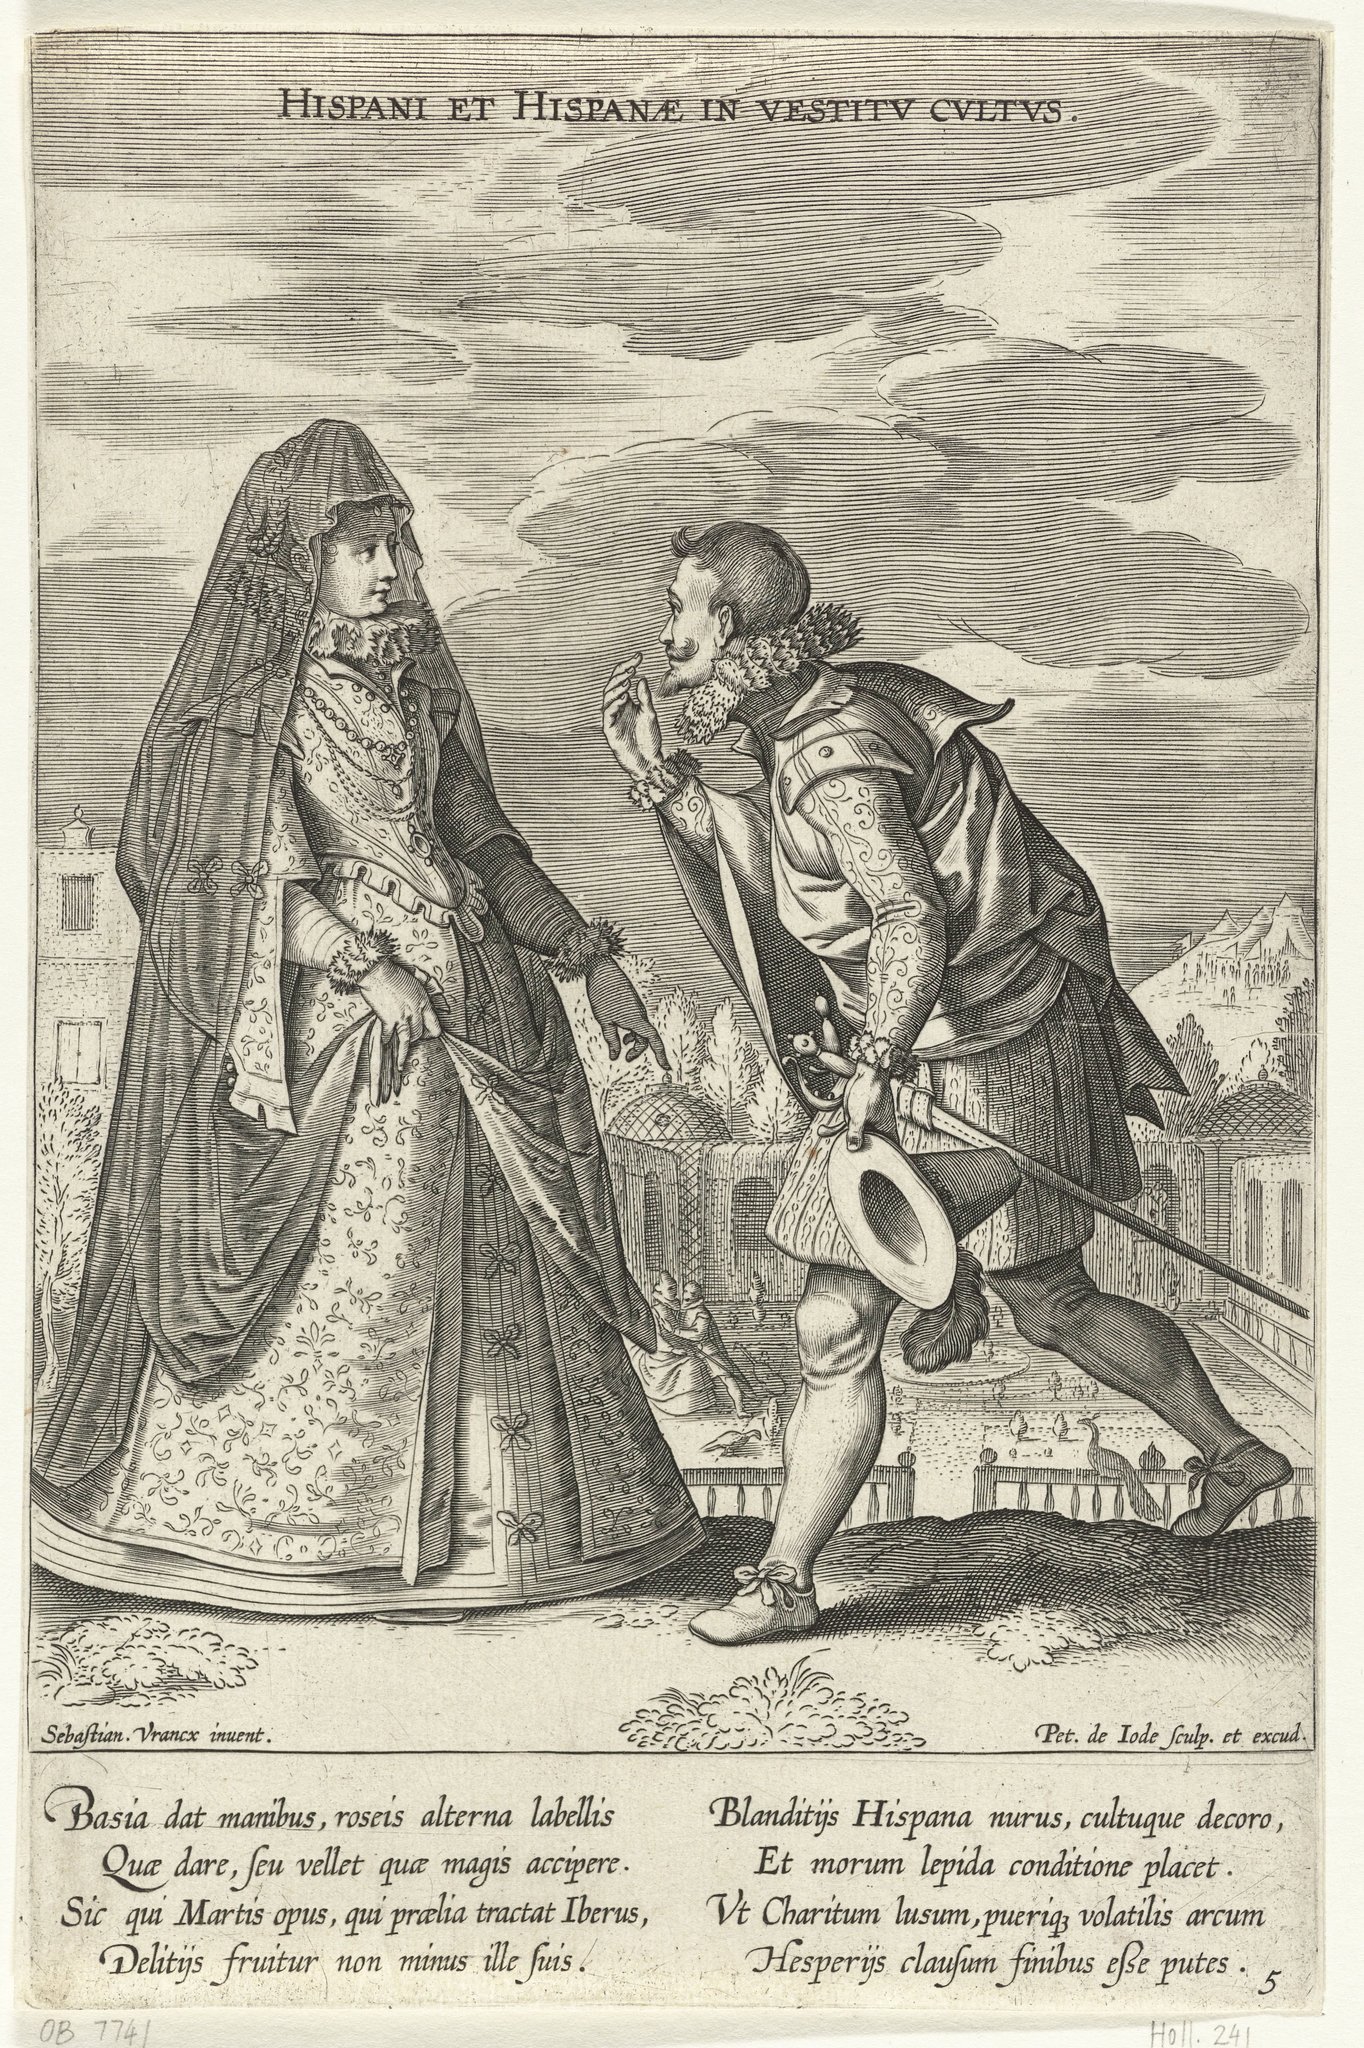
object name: costume print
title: Variarum Gentium Ornatus (Costumes of Different Nations)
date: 1605-1610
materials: paper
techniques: engraving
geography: antwerp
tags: europeans: spaniards, neck-gear ~ clothing (with name) (+ men's clothes), veil (+ women's clothes), sleeves, coat (+ men's clothes), dress, gown (vlieger) (+ women's clothes), head-gear: hat (+ men's clothes), clothes, costume (+ women's clothes), neck-gear ~ clothing (with name) (+ women's clothes), hacking and thrusting weapons: sword, shoes, sandals (+ men's clothes), clothes, costume (+ men's clothes), folk costume, regional costume, trousers, breeches, etc. (breeches) (+ men's clothes), clothing for the upper part of the body (doublet) (+ men's clothes), spain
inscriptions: title: ‘HISPANI ET HISPANAE IN VESTITV CVLTVS.’, collector's mark: Lugt 240, caption: ‘Basia dat manibus, roseis alterna labellis / Quae dare, seu vellet quae magis accipere. / Sic qui Martis opus, qui proelia tractat Iberus, / Delitijs fruitur non minus ille suis./ Blanditijs Hispana nurus, cultuque decoro, / Et morum lepida conditione placet. Vt Charitum lusum, puerique volatilis arcum / Hesperijs clausum finibus esse putes.’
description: This series illustrates both the local scenery and the aristocratic fashions of Germany 1, France 2, Rome 3, Milan 4, the Netherlands 5 and Spain 6. Sometimes it is possible to spot famous monuments in the distance, such as Trajan’s Column in Rome. The inscriptions rarely refer to clothing, but plate 2 notes that the French constantly update their outfits – an oft-repeated stereotype of the period.